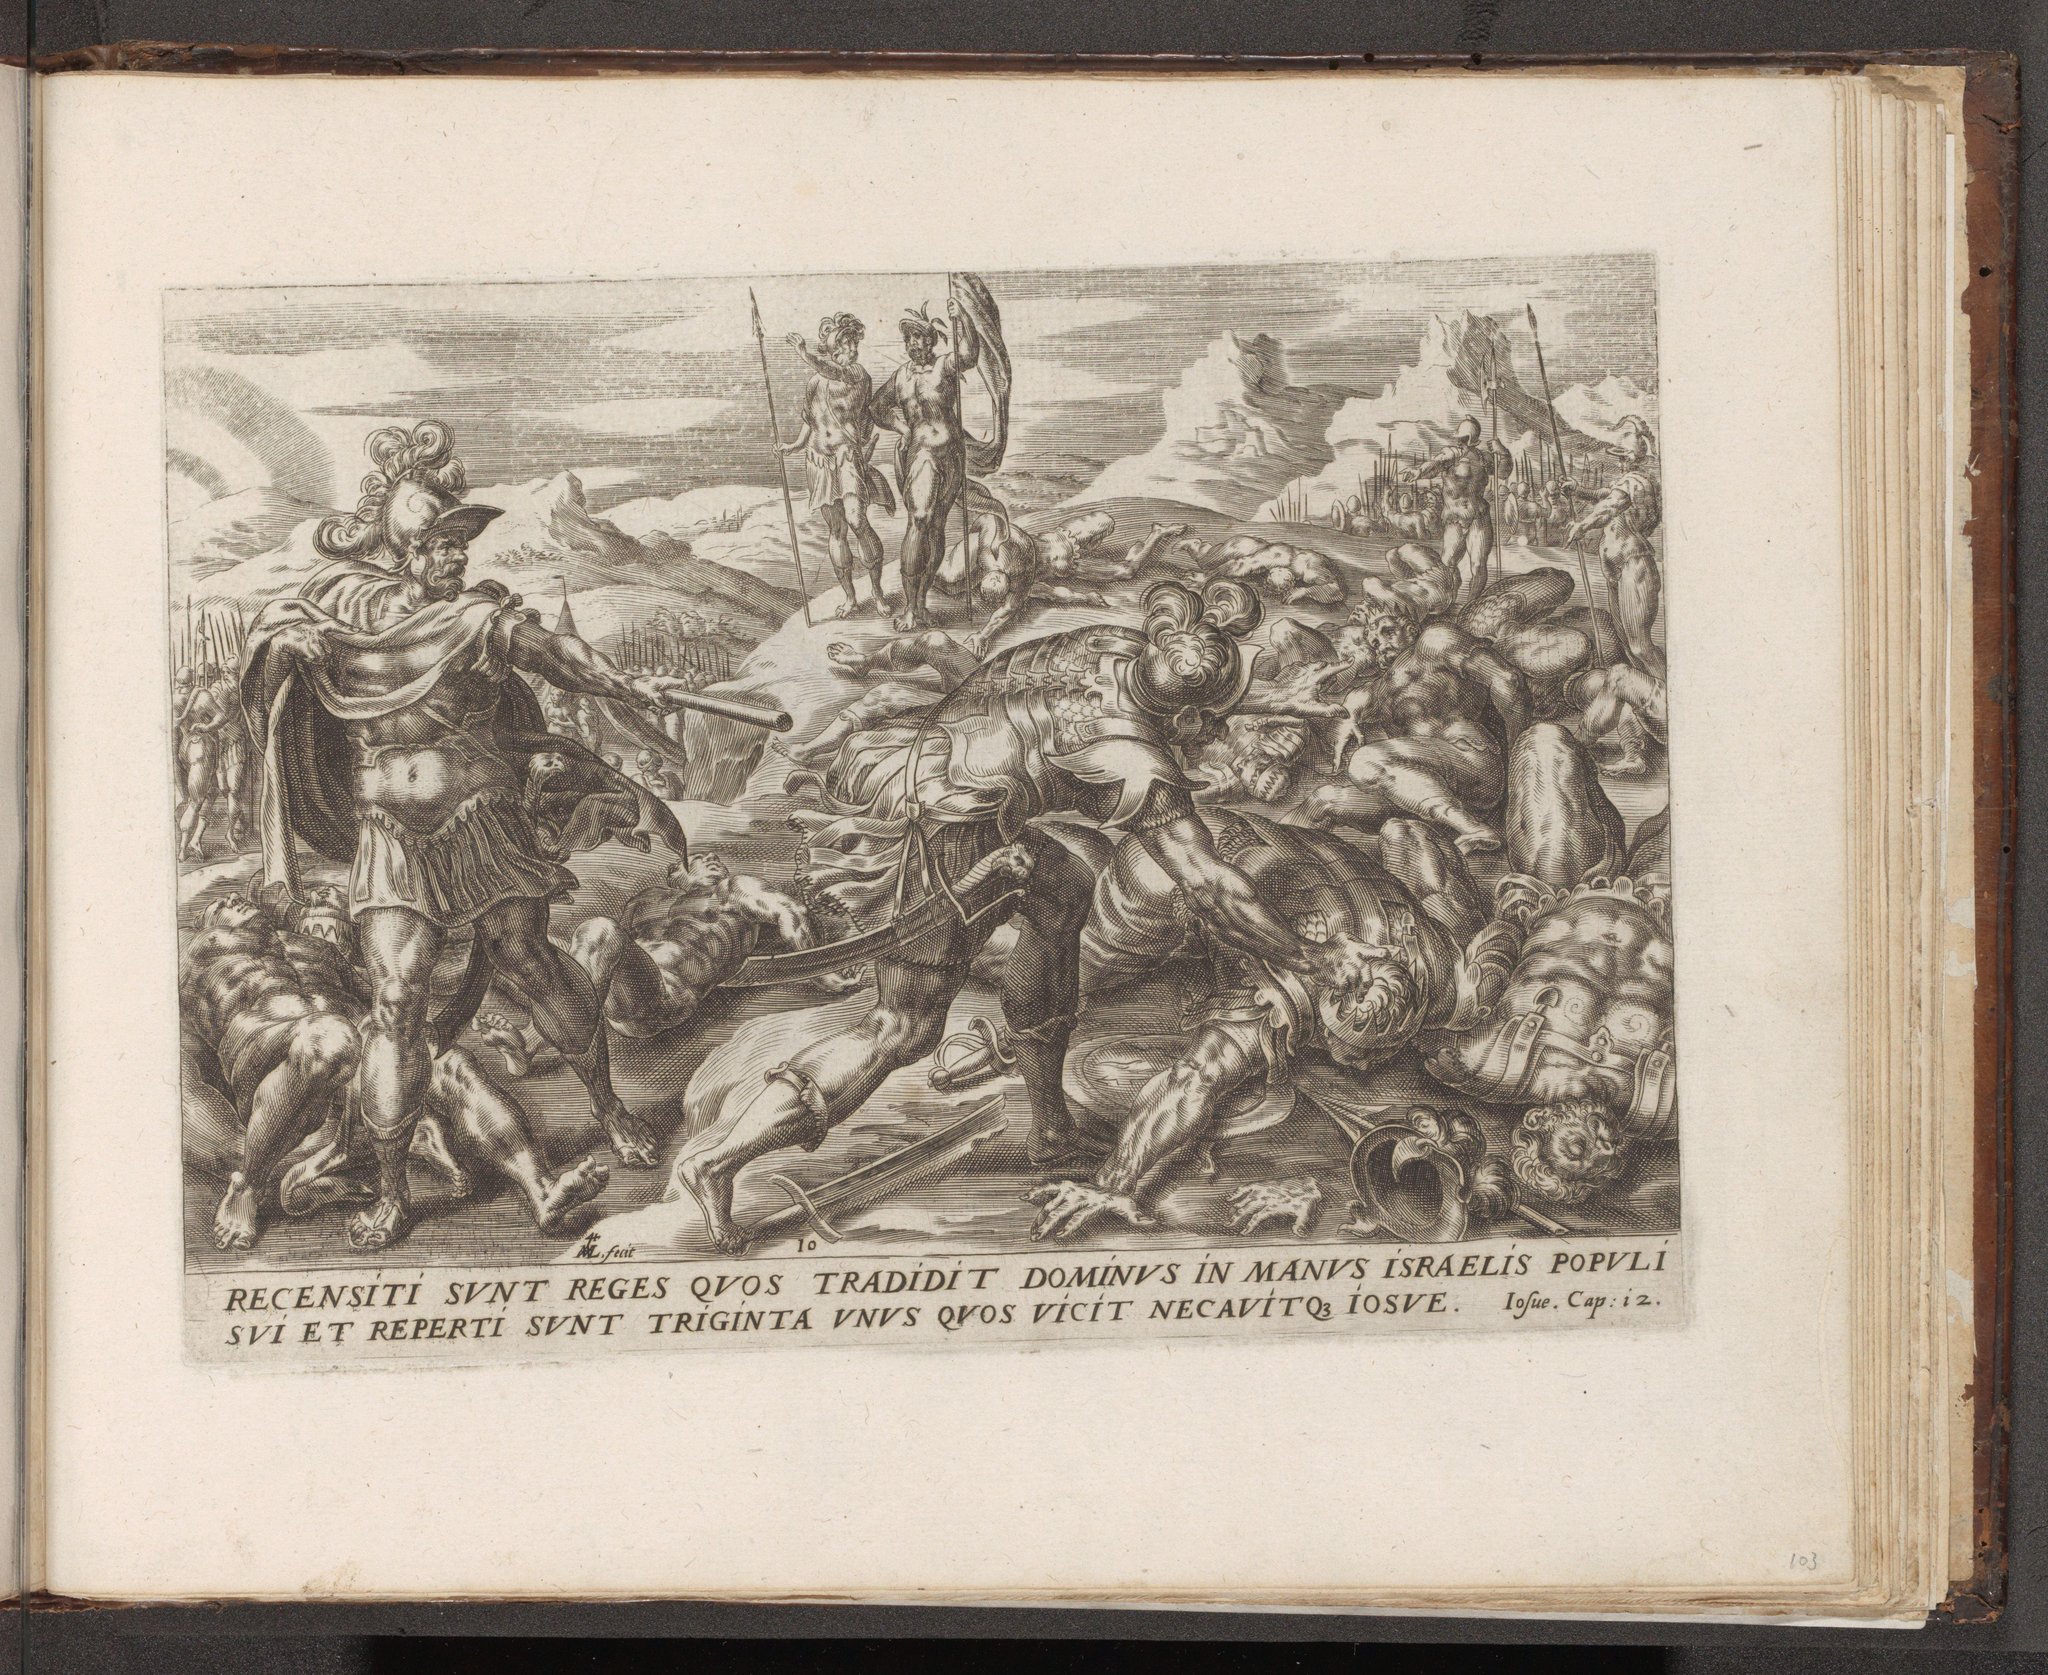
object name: album leaf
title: Eenendertig koningen verslagen door Jozua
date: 1579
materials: paper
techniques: engraving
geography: antwerp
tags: the territory of the thirty-one kings is conquered by joshua and his army (joshua 12:7-24)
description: Jozua staat links in een landschap en wijst naar de 31 koningen op de grond, die hij verslagen heeft. Onder de voorstelling een verwijzing in het Latijn naar de Bijbeltekst in Joz. 12. Prent maakt deel uit van een album.